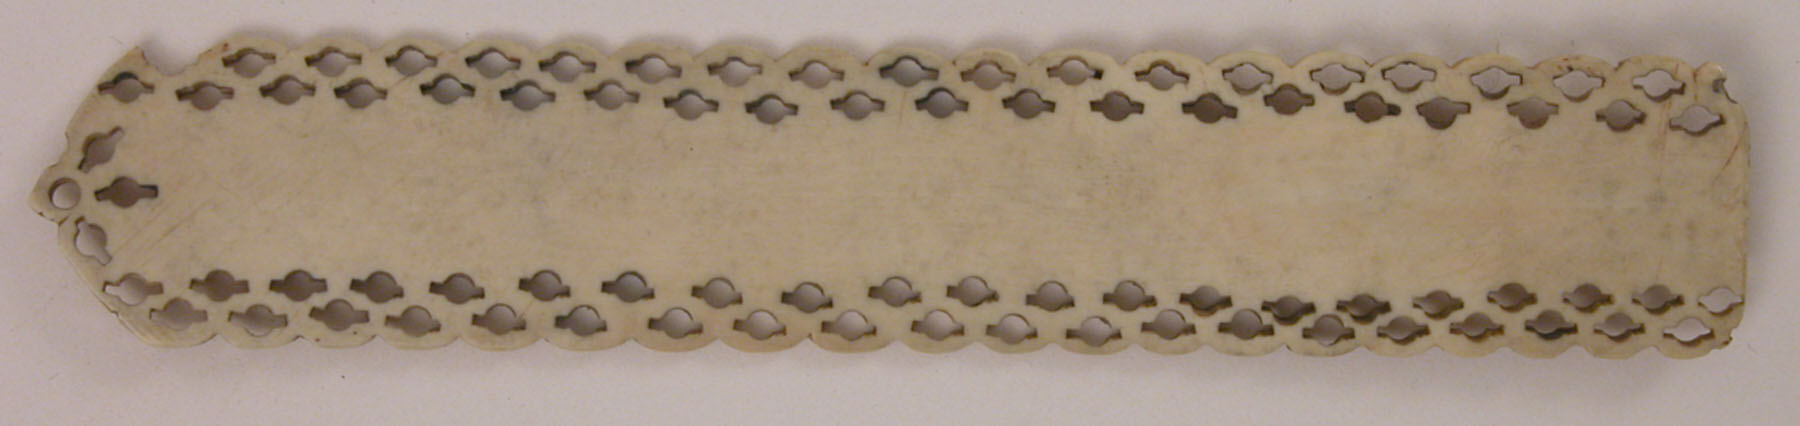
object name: pen rest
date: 1601-1800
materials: bone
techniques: carving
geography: turkey